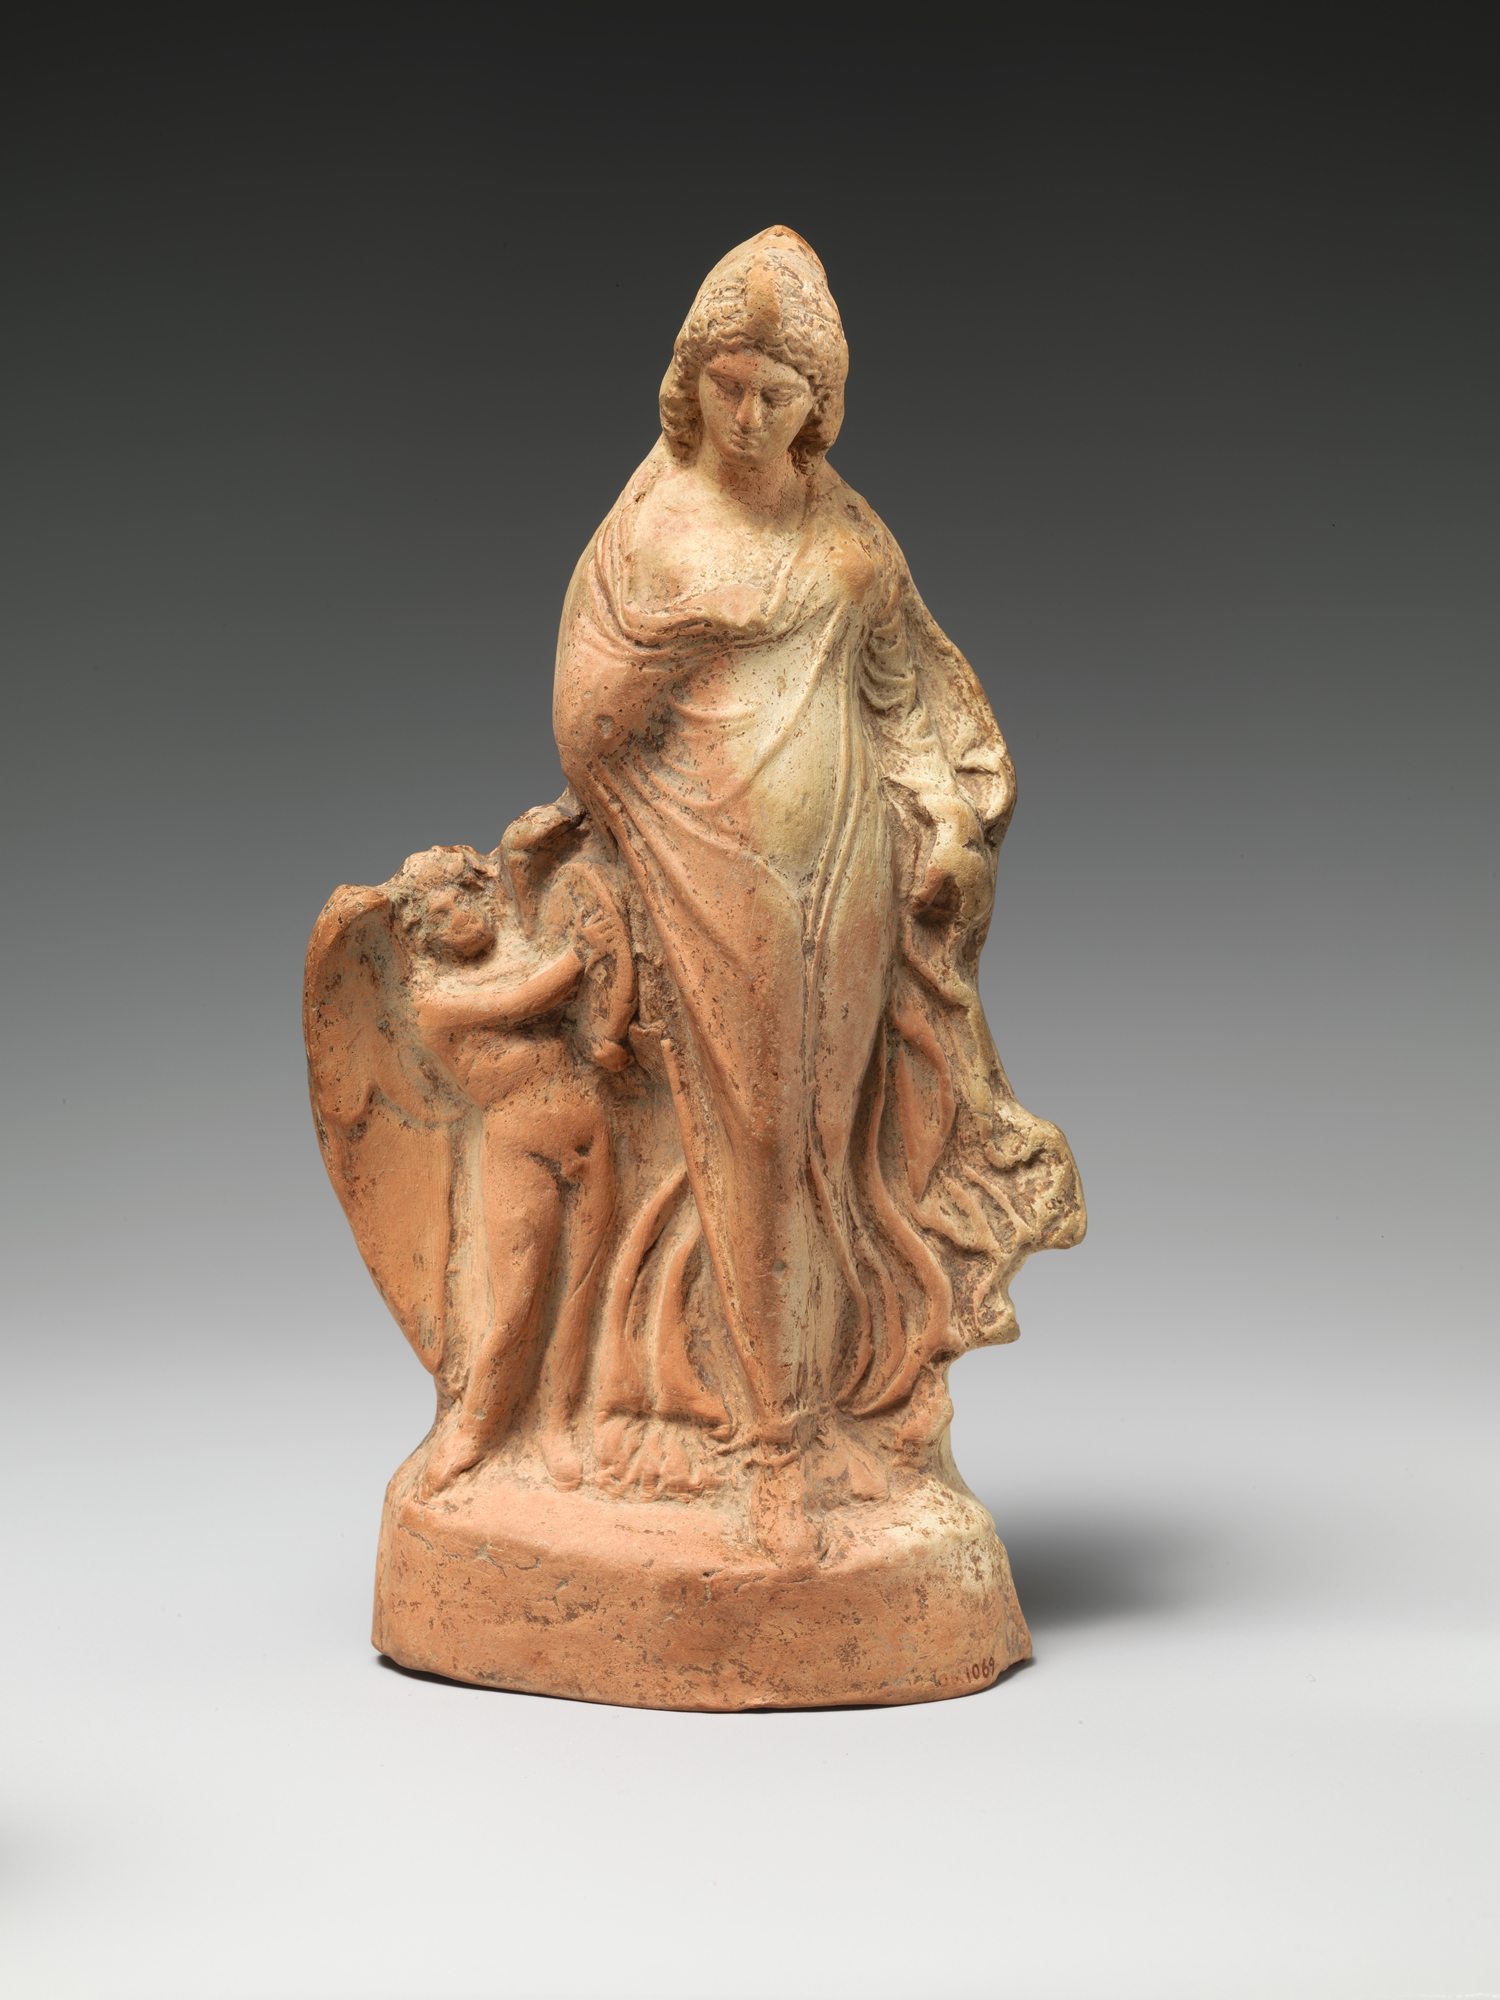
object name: statuette of aphrodite dancing with eros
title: Terracotta statuette of dancing Aphrodite with Eros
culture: greek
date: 400-368 BCE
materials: terracotta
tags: boys,women,dancing,aphrodite,eros